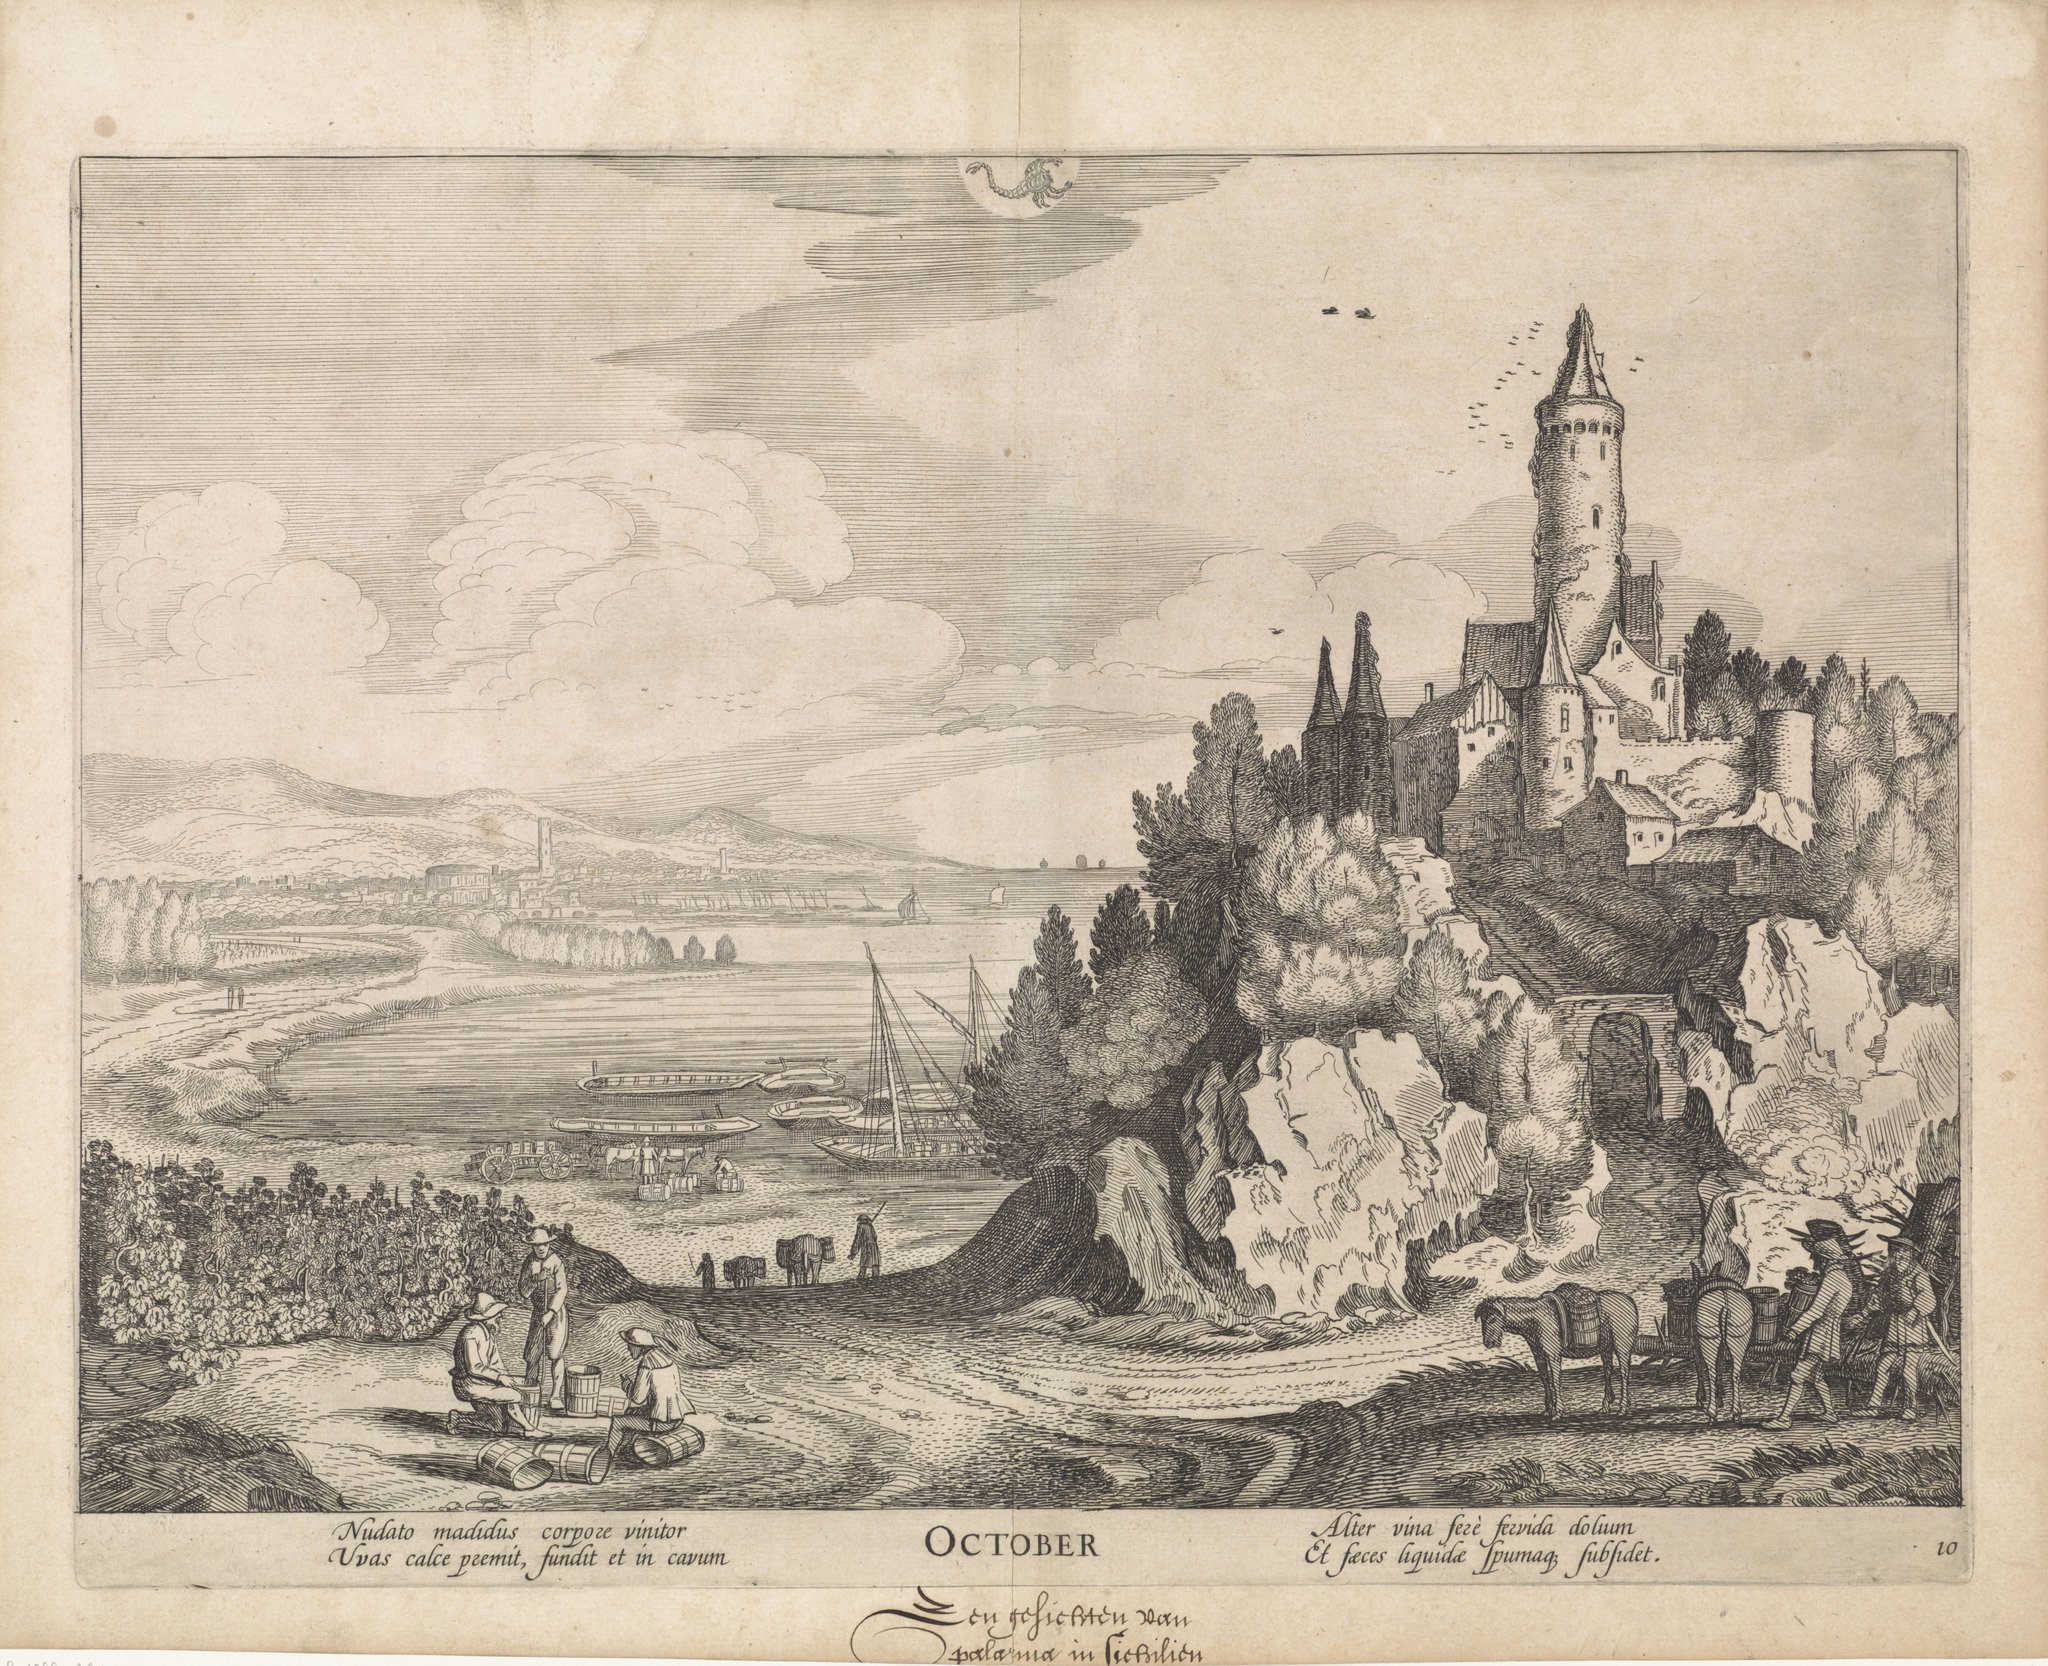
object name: print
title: De twaalf maanden, met dorpsgezichten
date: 1618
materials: paper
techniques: etching, pen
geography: northern netherlands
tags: landscape symbolizing october, vineyard, castle, october and its 'labours', scorpio (zodiacal sign of october), transport of grapes, viticulture, wine-growing; vintage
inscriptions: caption: ‘Een gesichten van Palarma in Sichilien’, collector's mark: Lugt 2228